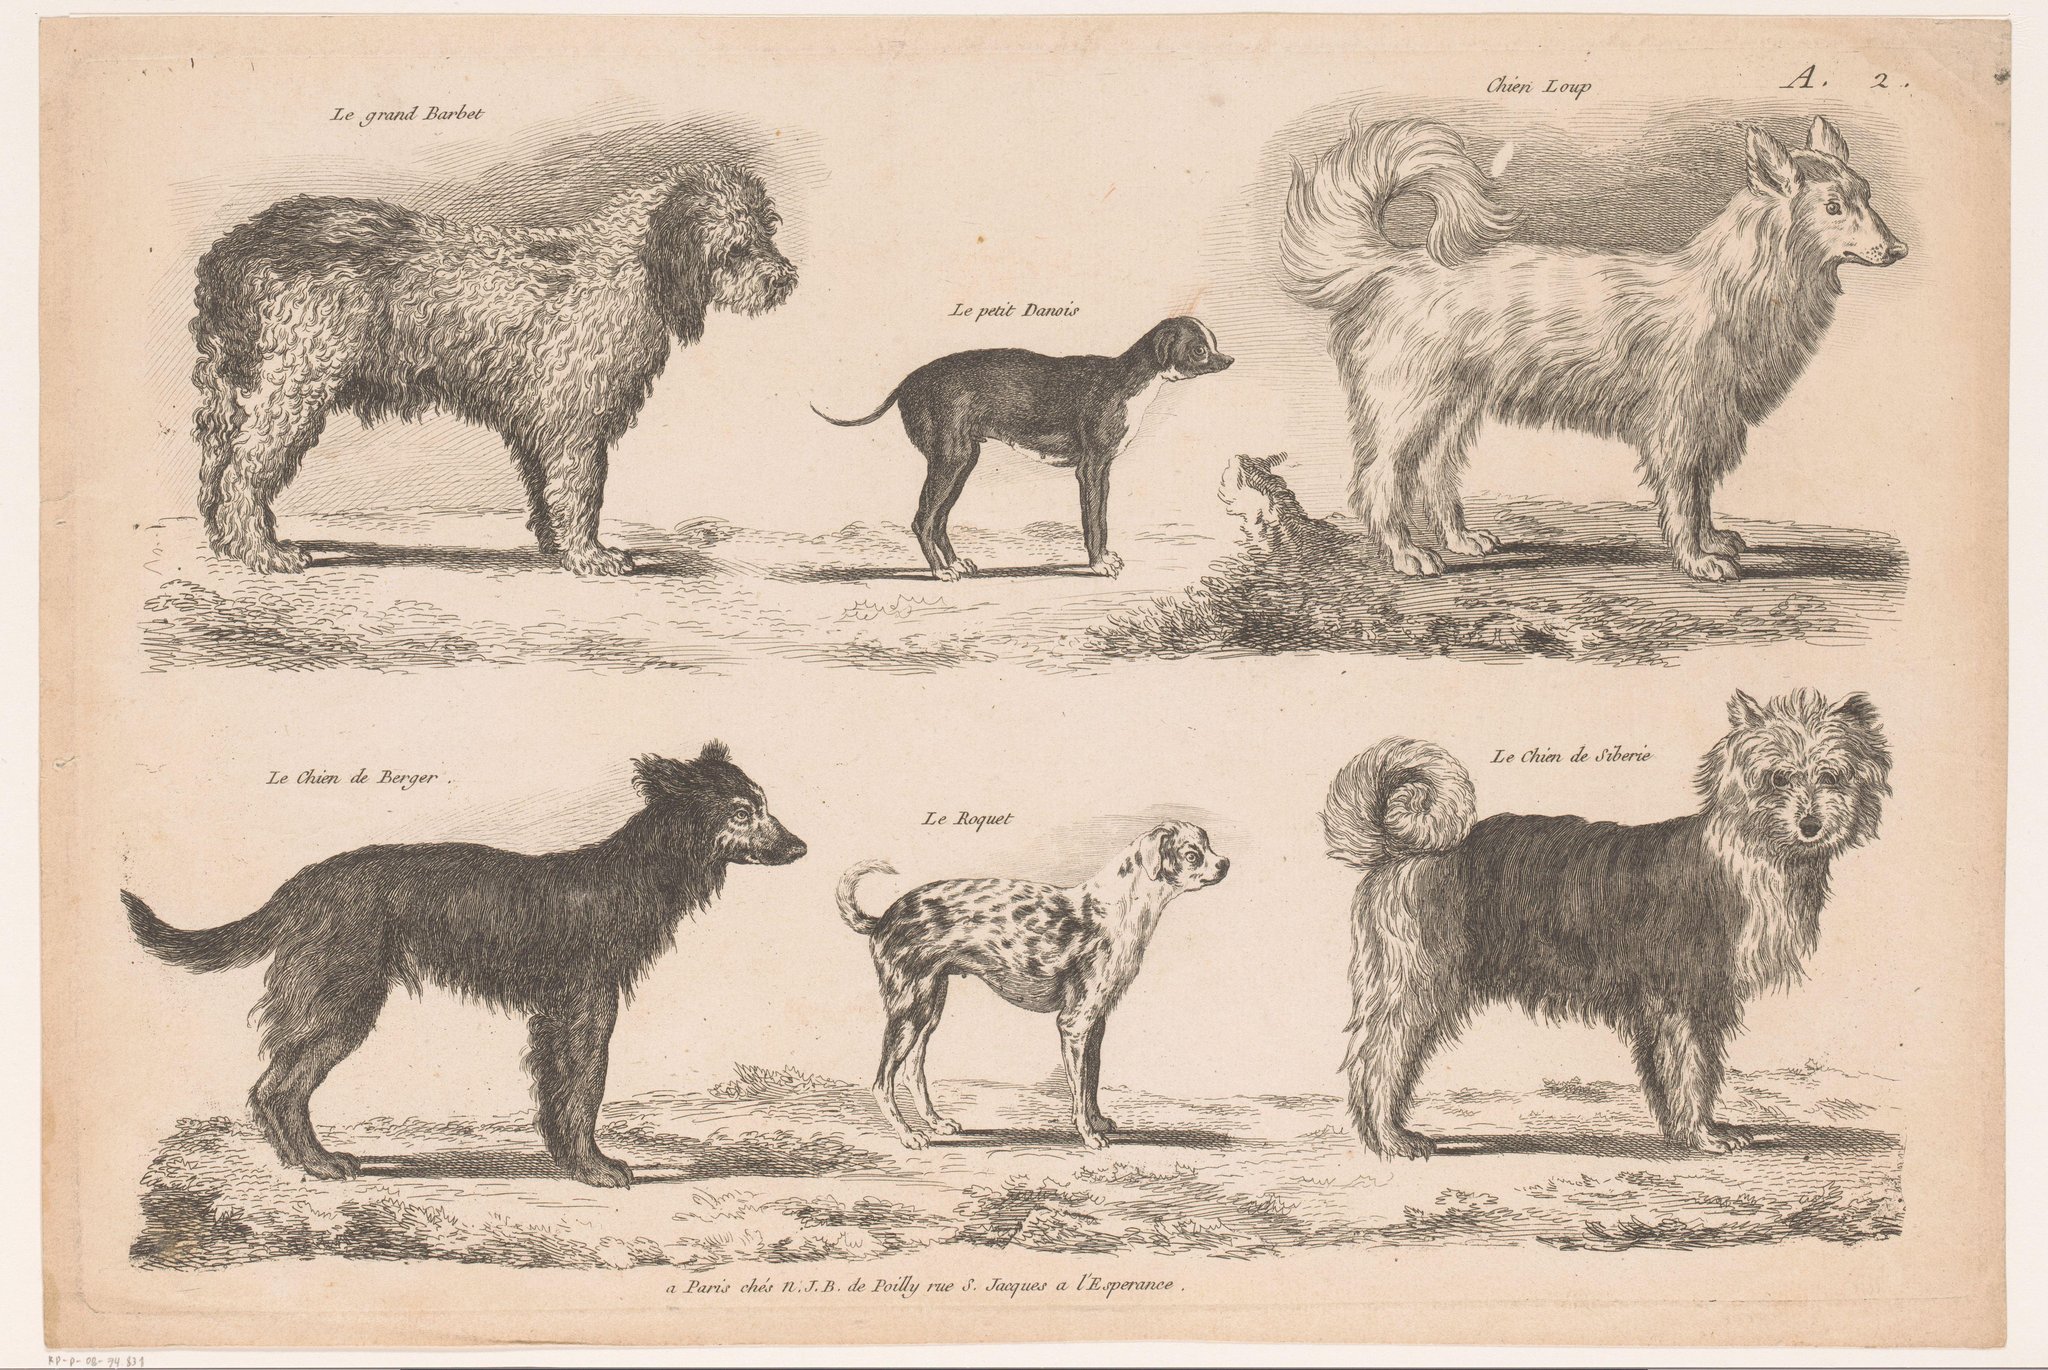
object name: print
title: Verschillende hondenrassen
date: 1750-1820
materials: paper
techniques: engraving, etching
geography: paris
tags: dog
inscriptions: collector's mark: Lugt 2228, watermark